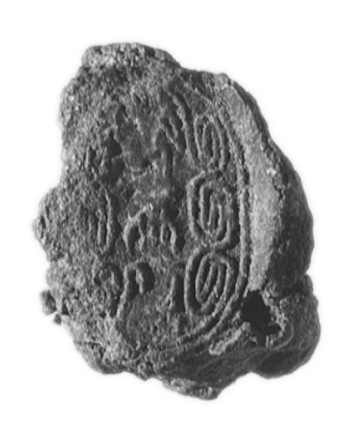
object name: sealing fragment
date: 2030-1640 BCE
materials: clay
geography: egypt